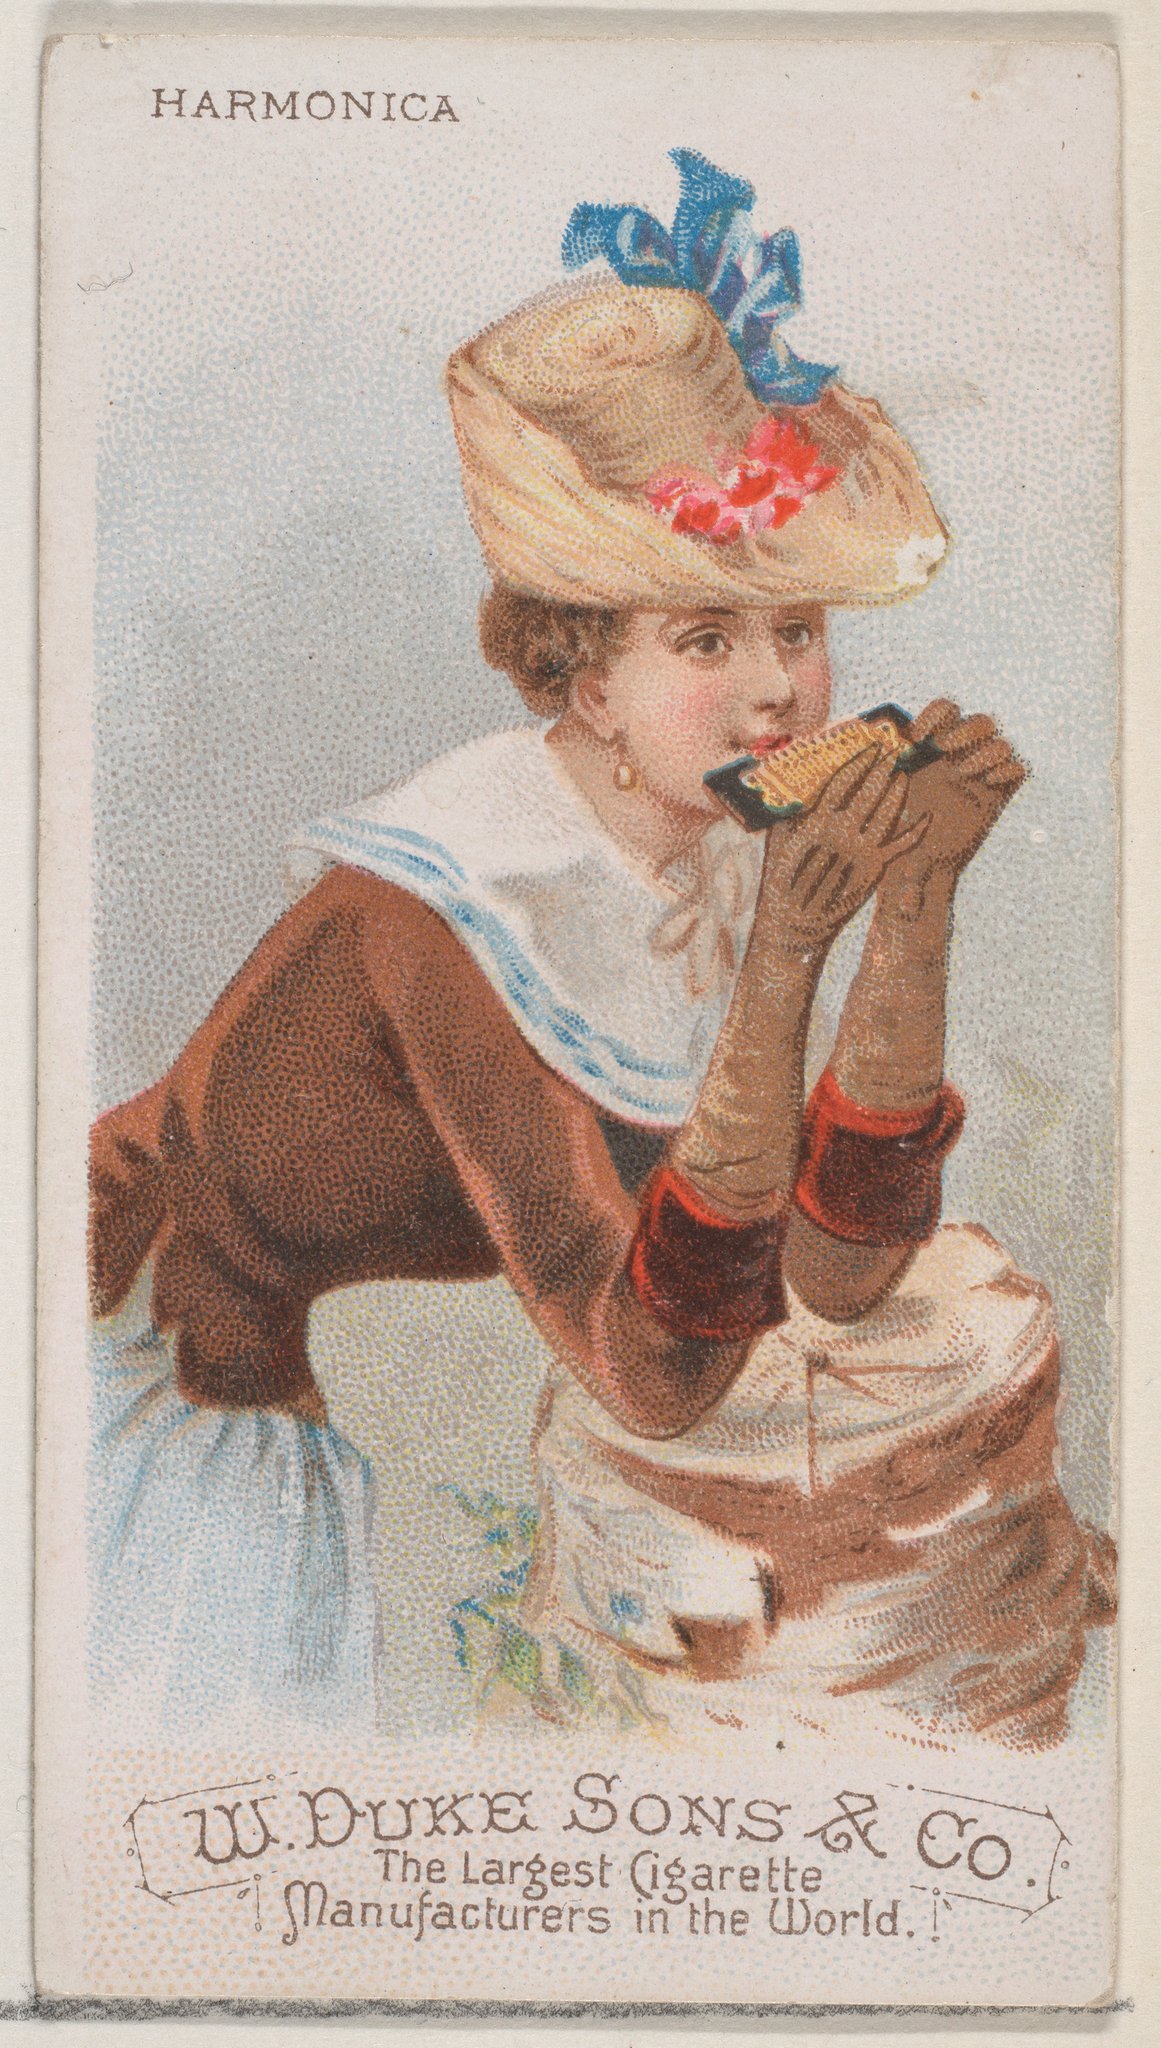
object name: print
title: Harmonica, from the Musical Instruments series (N82) for Duke brand cigarettes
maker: w. duke, sons & co.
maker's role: publisher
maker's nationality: american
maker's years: 1870-1920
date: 1888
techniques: color lithograph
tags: musical instruments,women,musicians